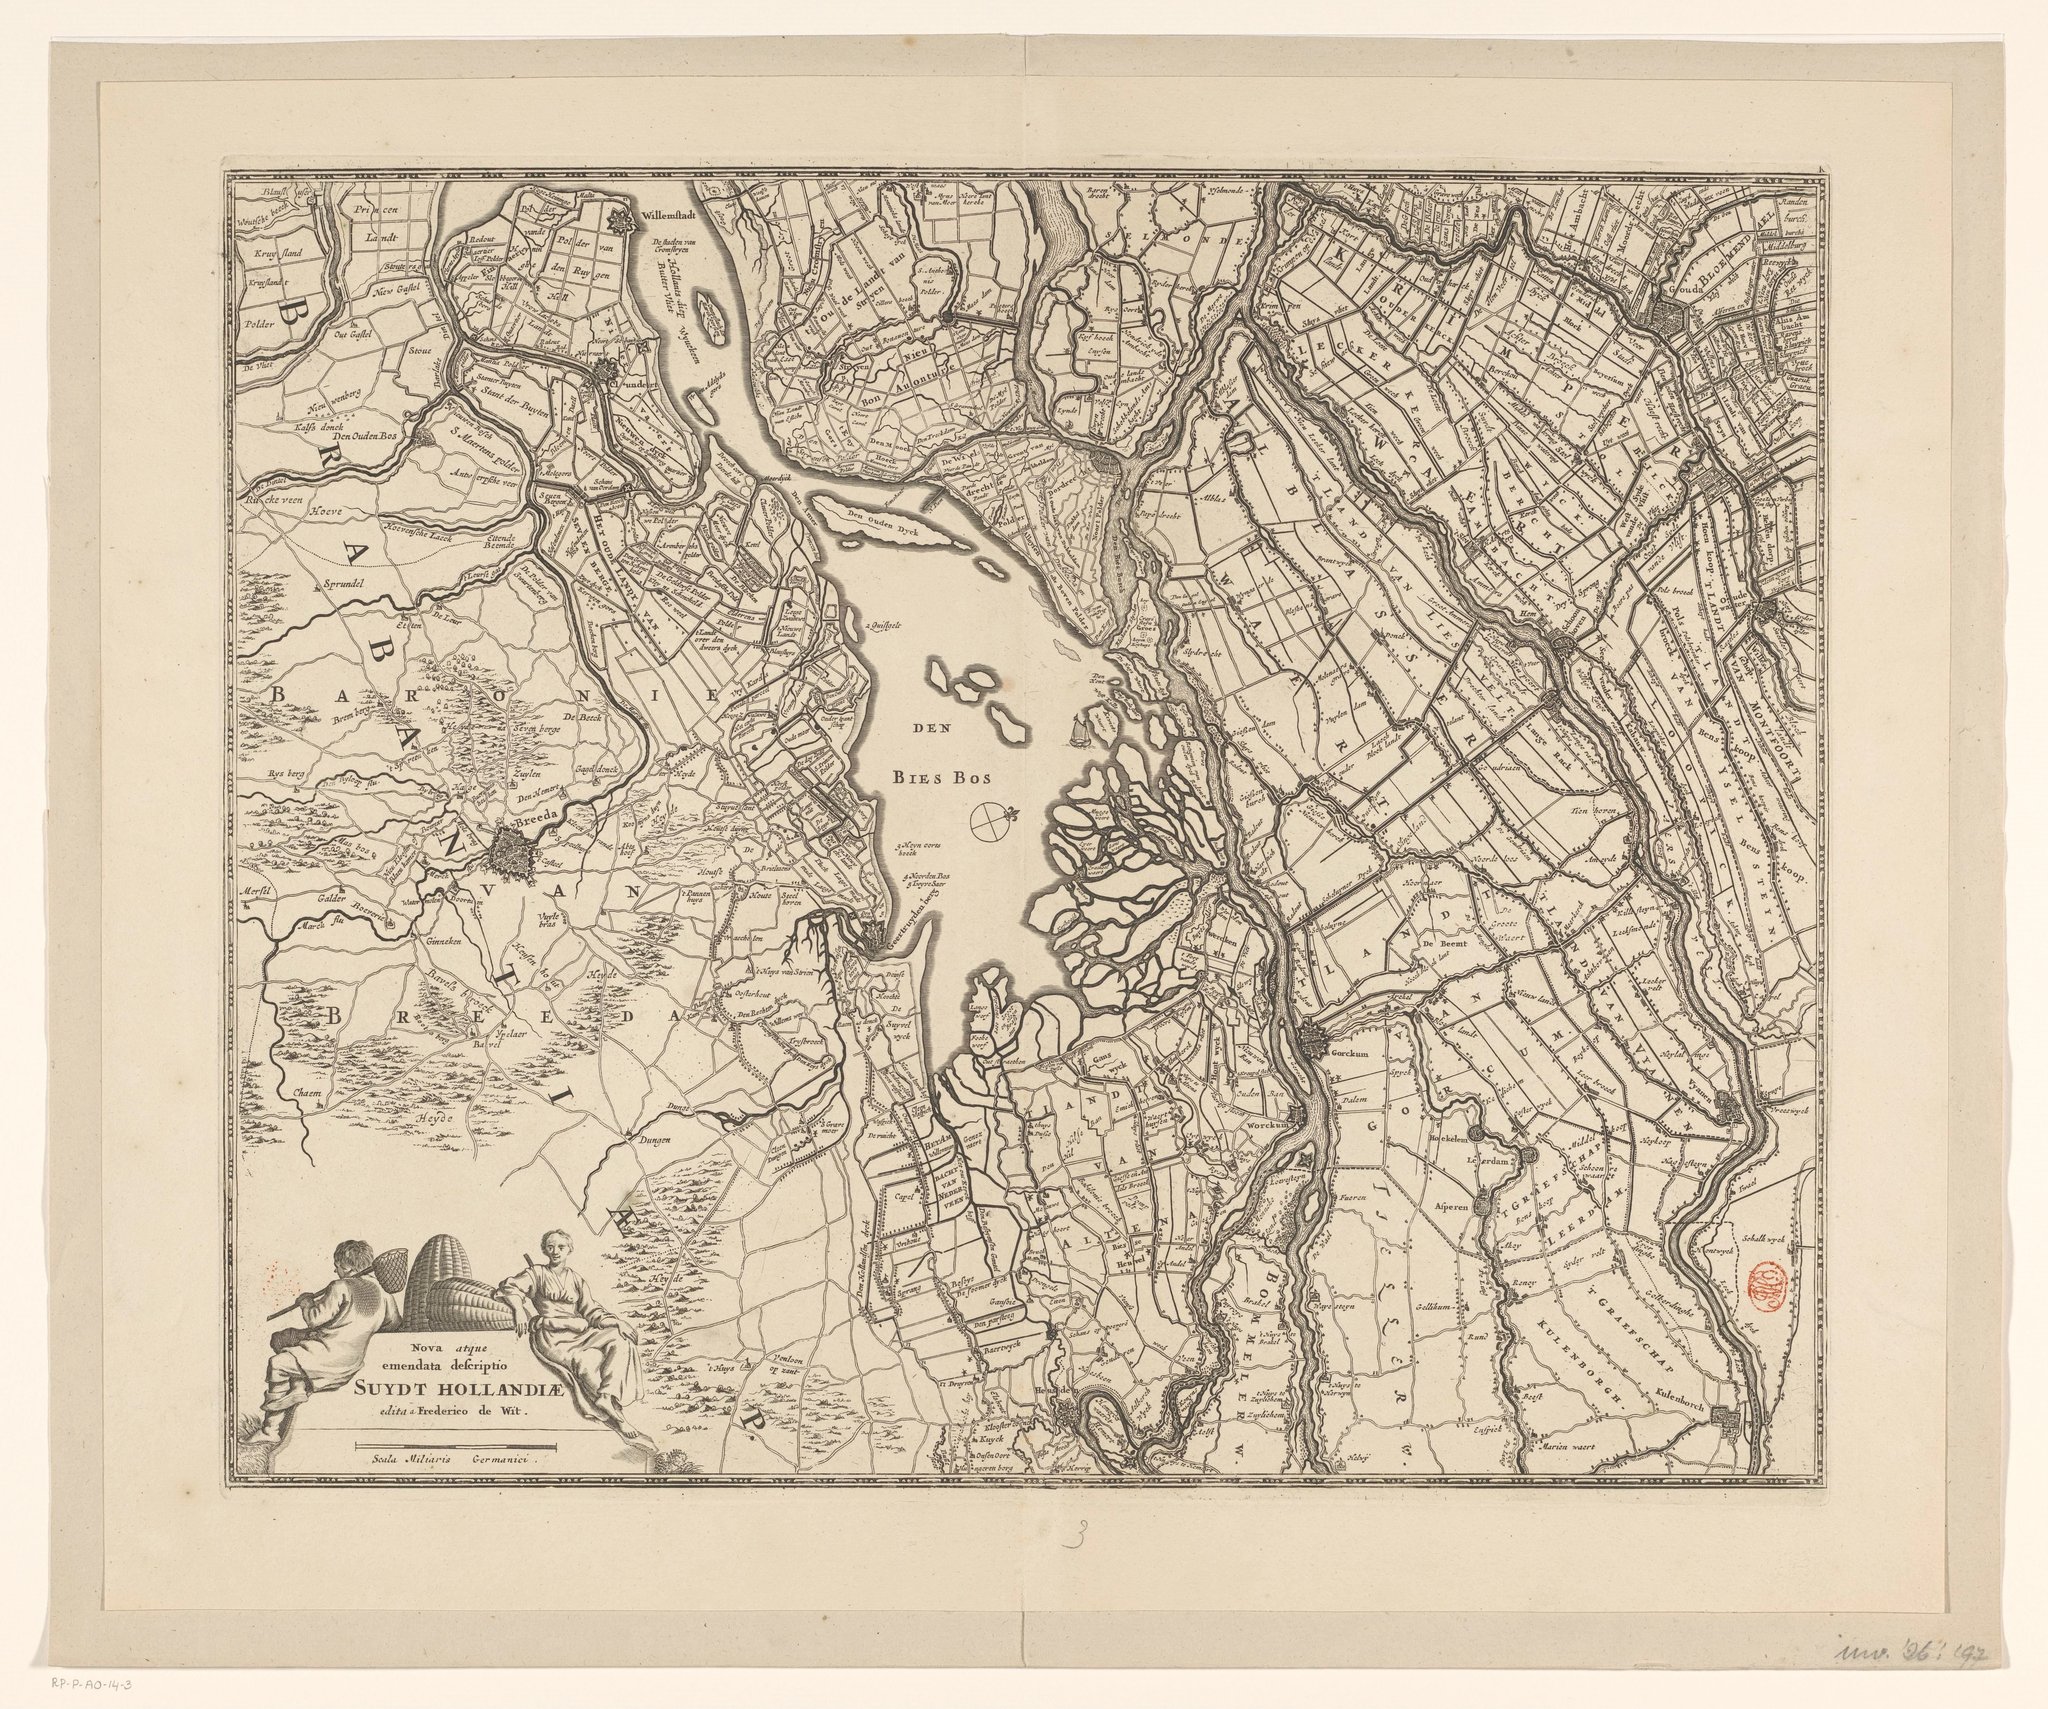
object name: print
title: Nova atque emendata descriptio Suyt Hollandiae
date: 1688-1710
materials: paper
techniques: engraving, etching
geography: amsterdam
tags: maps of separate countries or regions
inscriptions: collector's mark: Lugt 195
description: Kaart van een deel van Zuid-Holland rond de Biesbos. Linksonder een cartouche met de titel en een schaalstok: Scala miliaris Germanici. Rechtsboven gemerkt: K. Oriëntatie: noorden rechts.